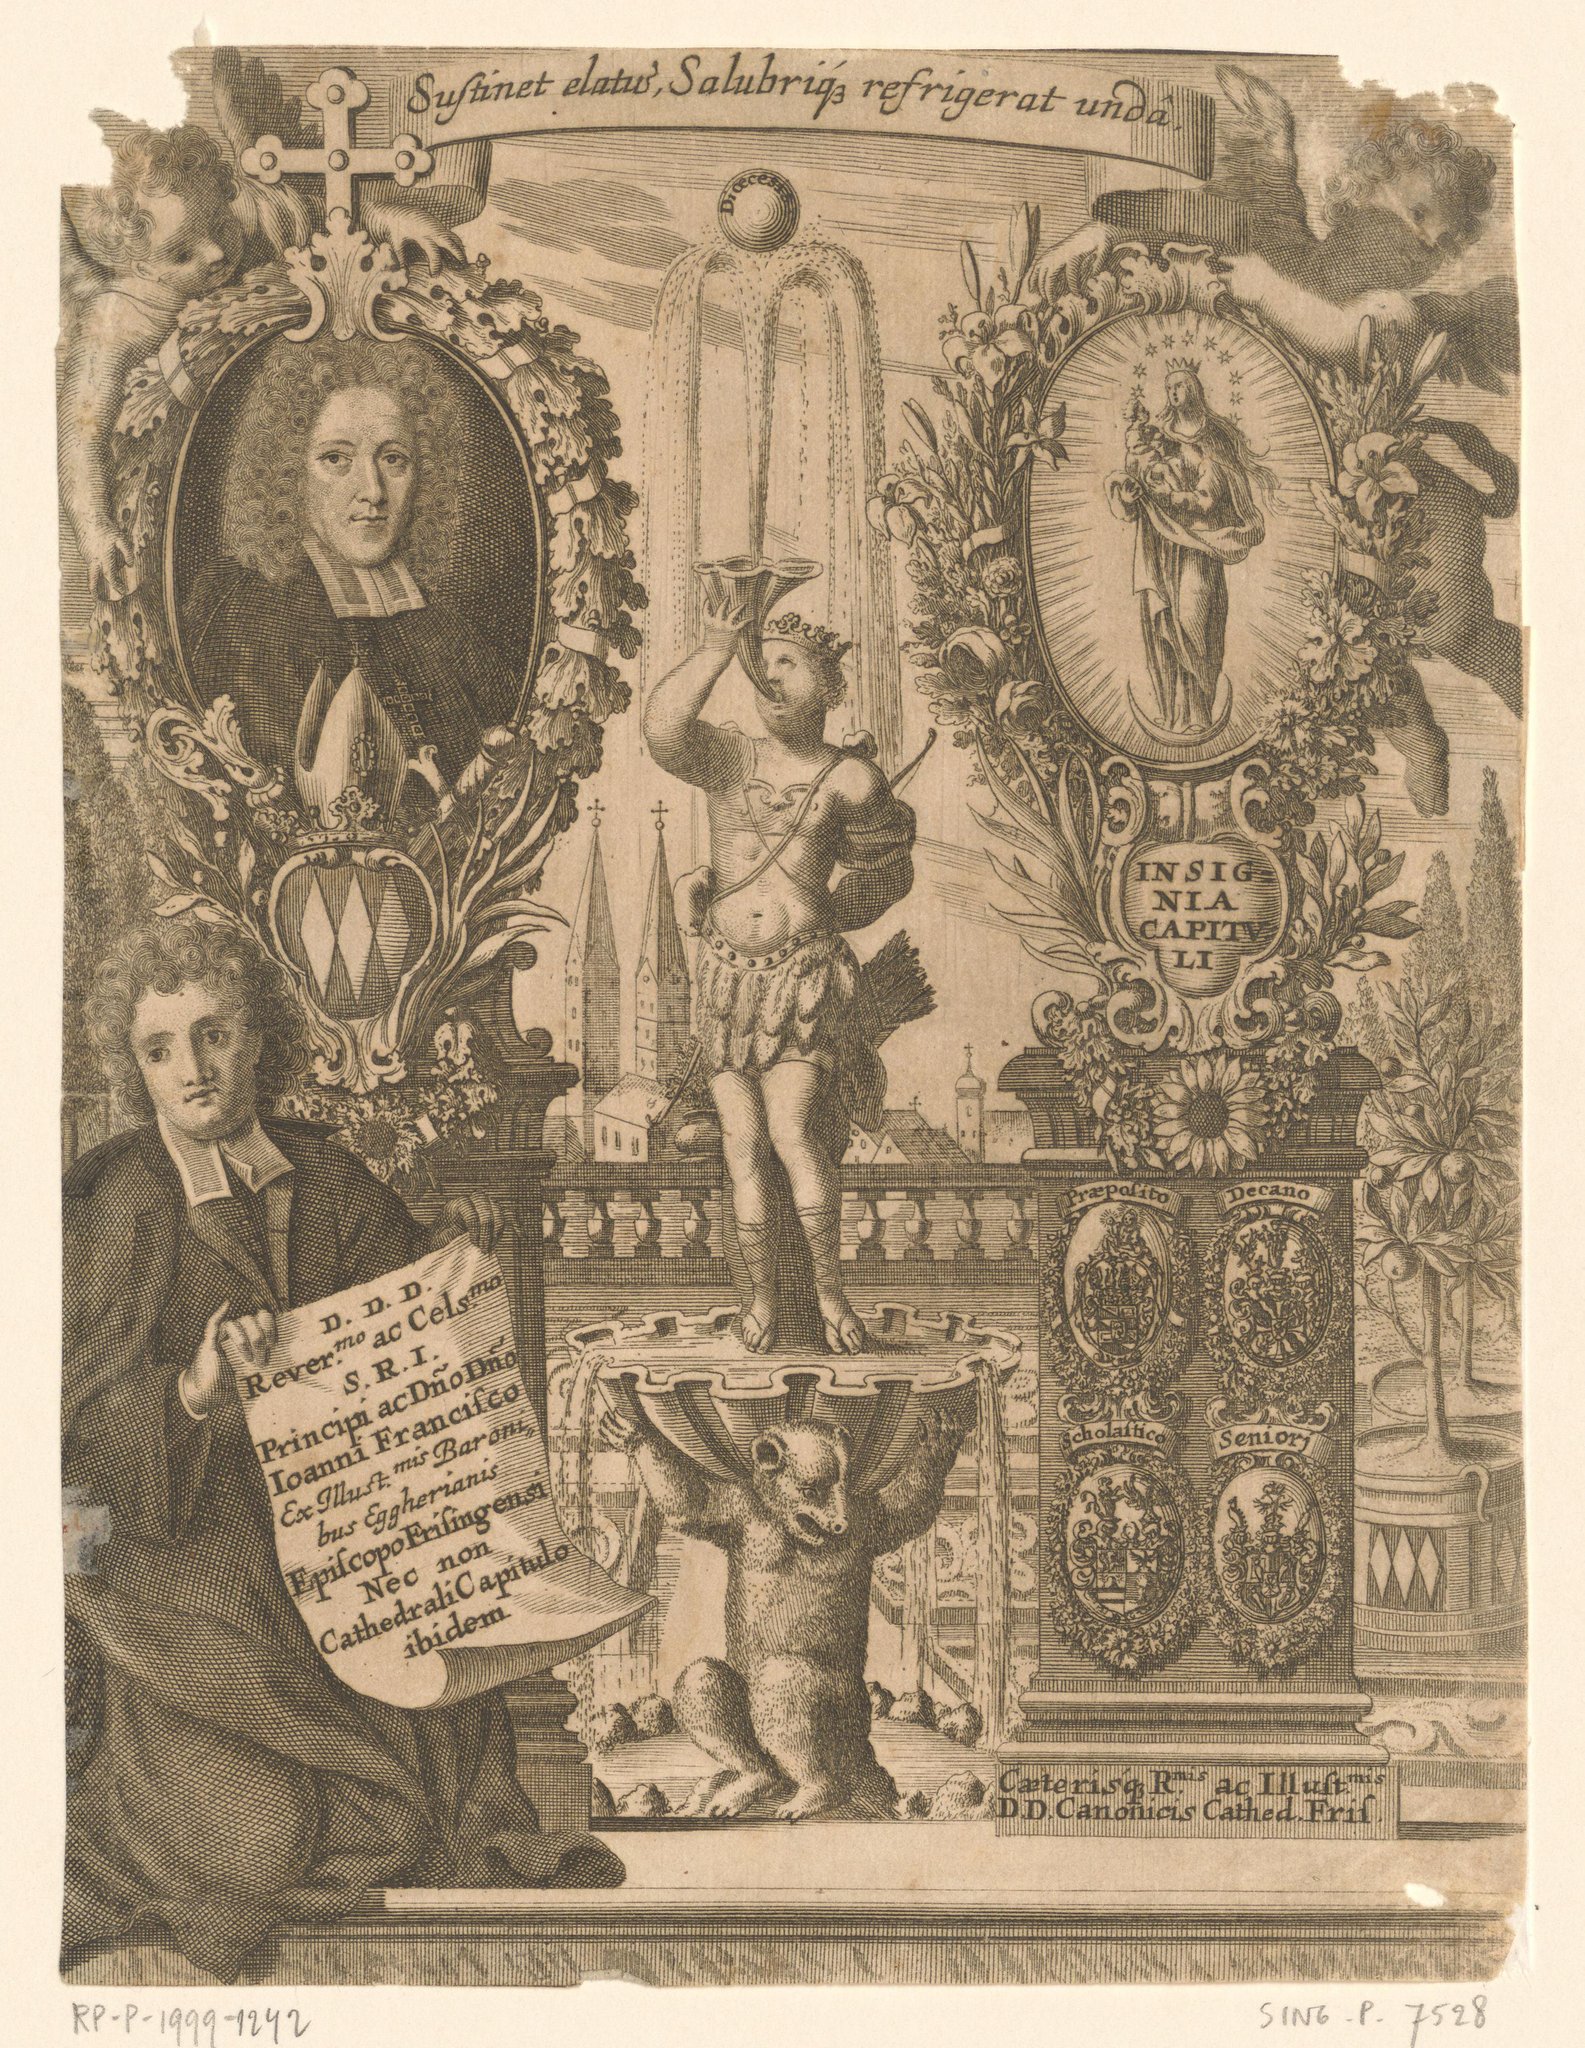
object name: print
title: Portret van Johann Franz Eckher von Kapfing und Liechteneck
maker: Anonymous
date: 1696-1727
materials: paper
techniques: engraving, etching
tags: clergyman, archbishop, bishop, etc. (roman catholic), historical persons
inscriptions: collector's mark: Lugt 2760, collector's mark: Lugt 2228, collector's mark: Lugt 4099, collector's mark: Lugt 1238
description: Portret van de bisschop van Freising in ovale lauwerkrans, vastgehouden door een putto. Rechts Madonna op de maansikkel in ovale omlijsting. In het midden een fontein en op de achtergrond een kerk. Linksvoor een man in toga die een titelblad ophoudt.